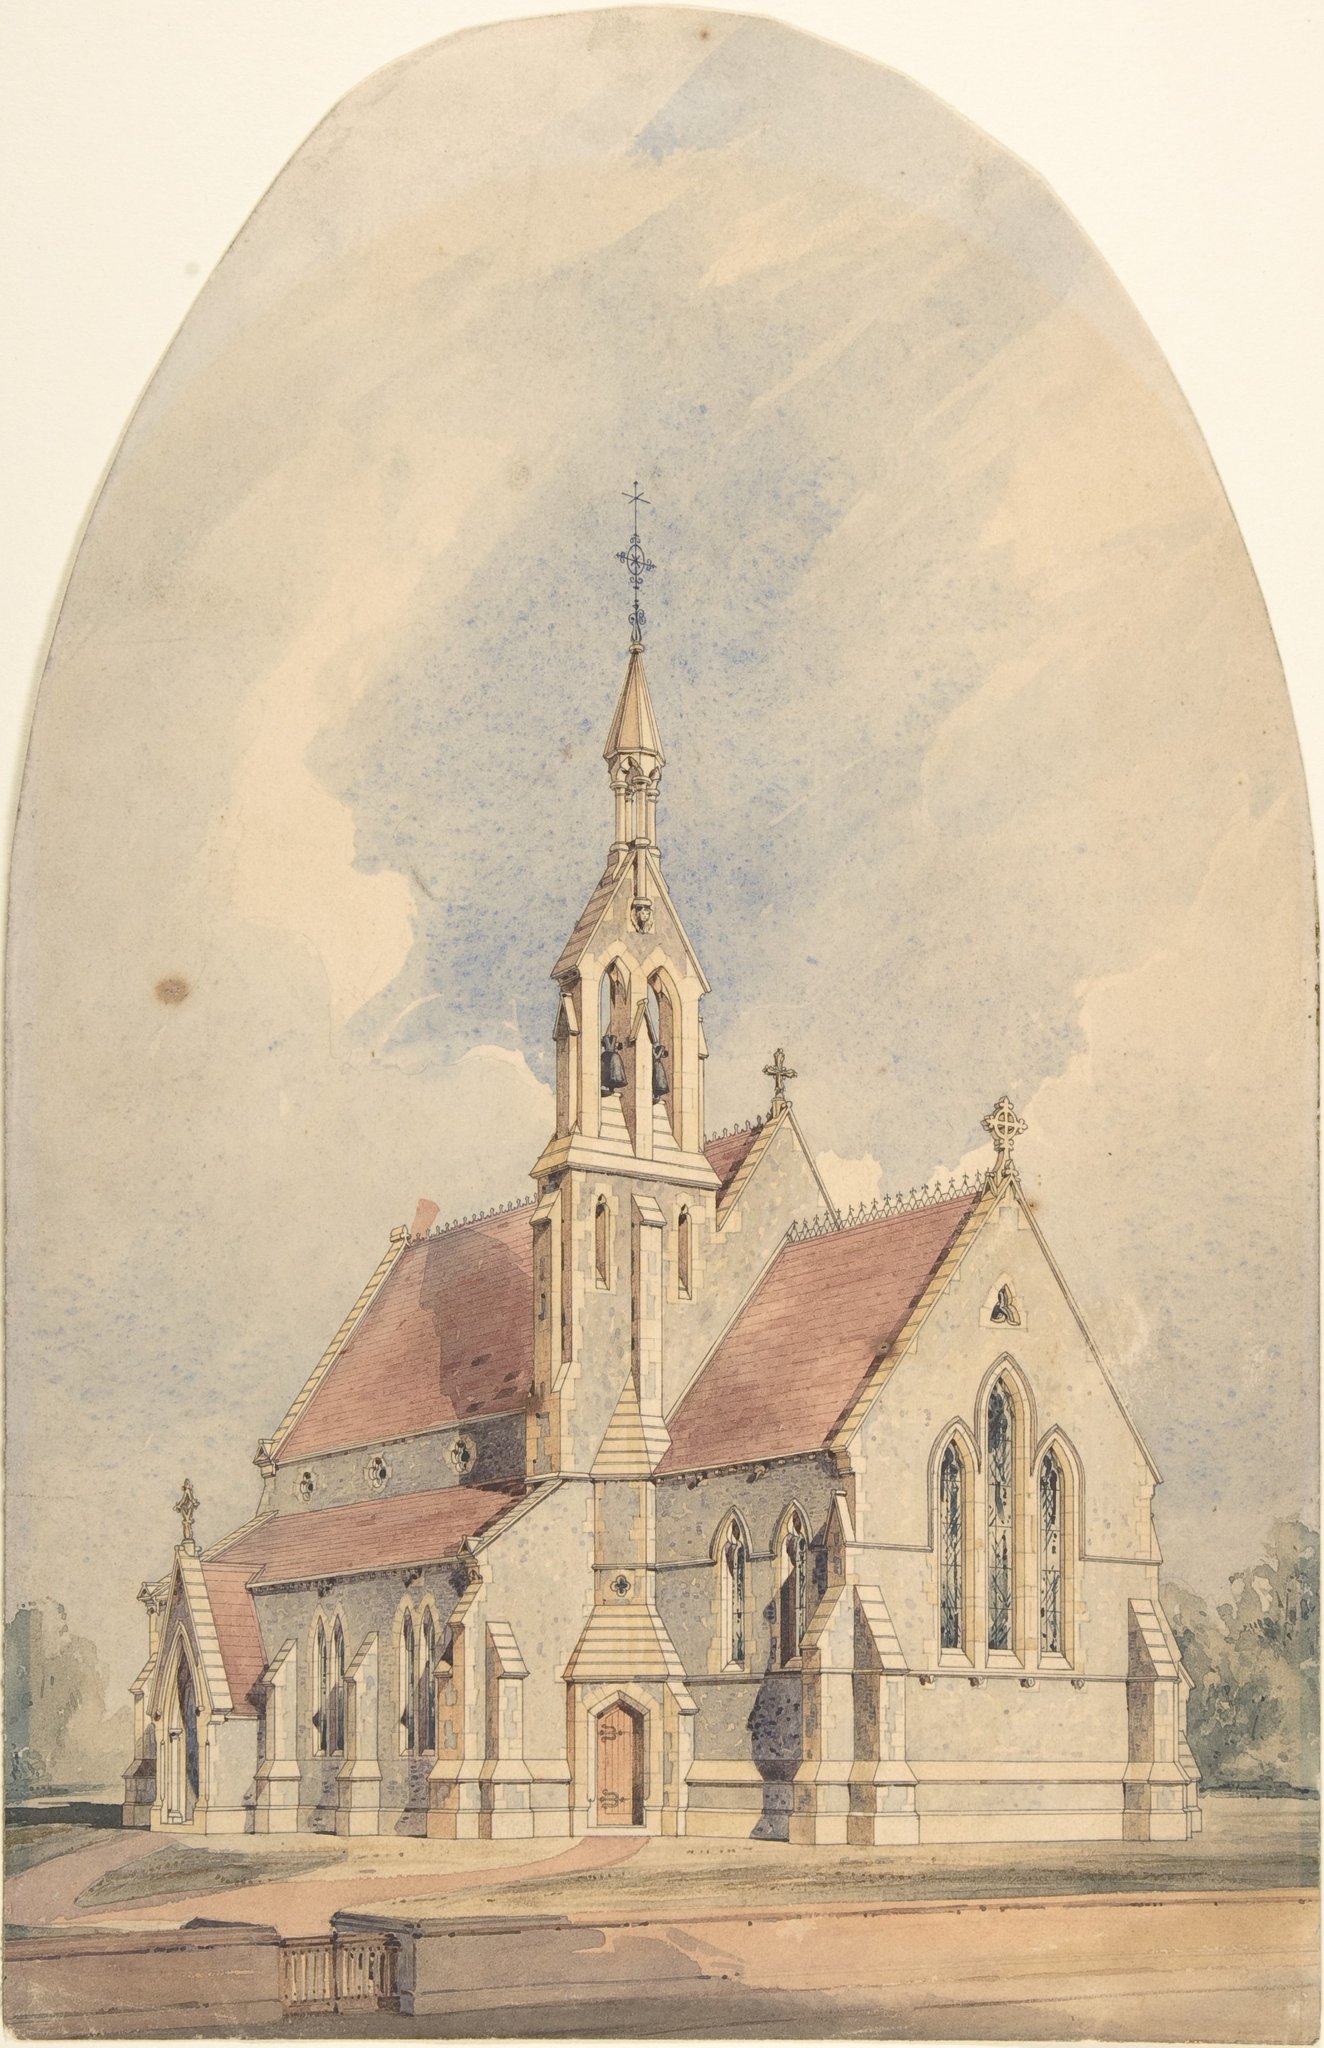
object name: drawing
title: Architectural Rendering of a Gothic Revival Church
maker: anonymous, british, 19th century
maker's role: artist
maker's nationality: british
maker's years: 1800-1900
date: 1850-1870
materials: watercolor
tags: churches